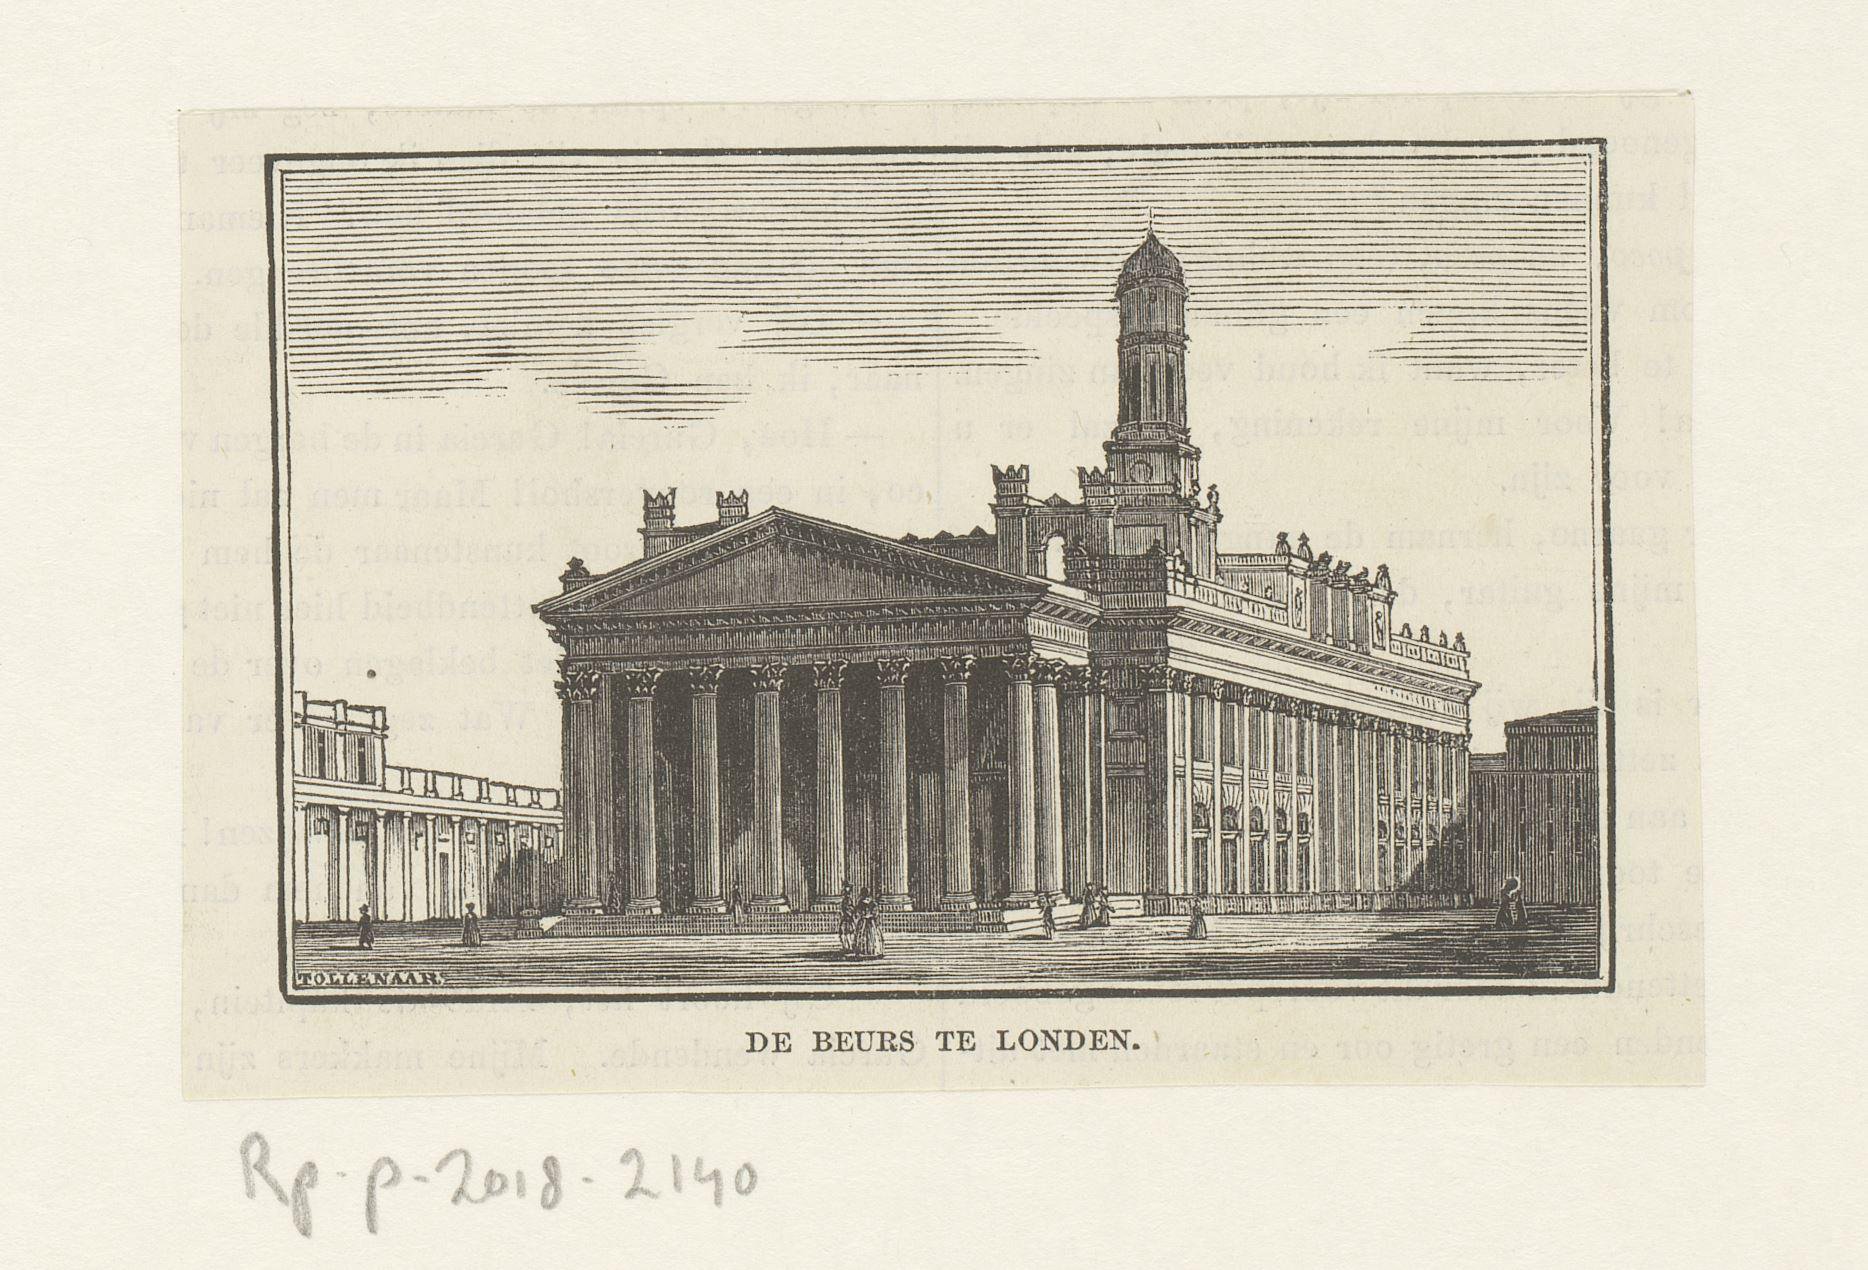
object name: print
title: De Beurs te Londen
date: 1847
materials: paper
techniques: letterpress printing, engraving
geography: amsterdam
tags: exchange, bourse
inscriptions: collector's mark: Lugt 2228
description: Prent gebruikt in: Hollandsch Penning-Magazijn voor de jeugd. Amsterdam: J.H. Laarman, 1847.